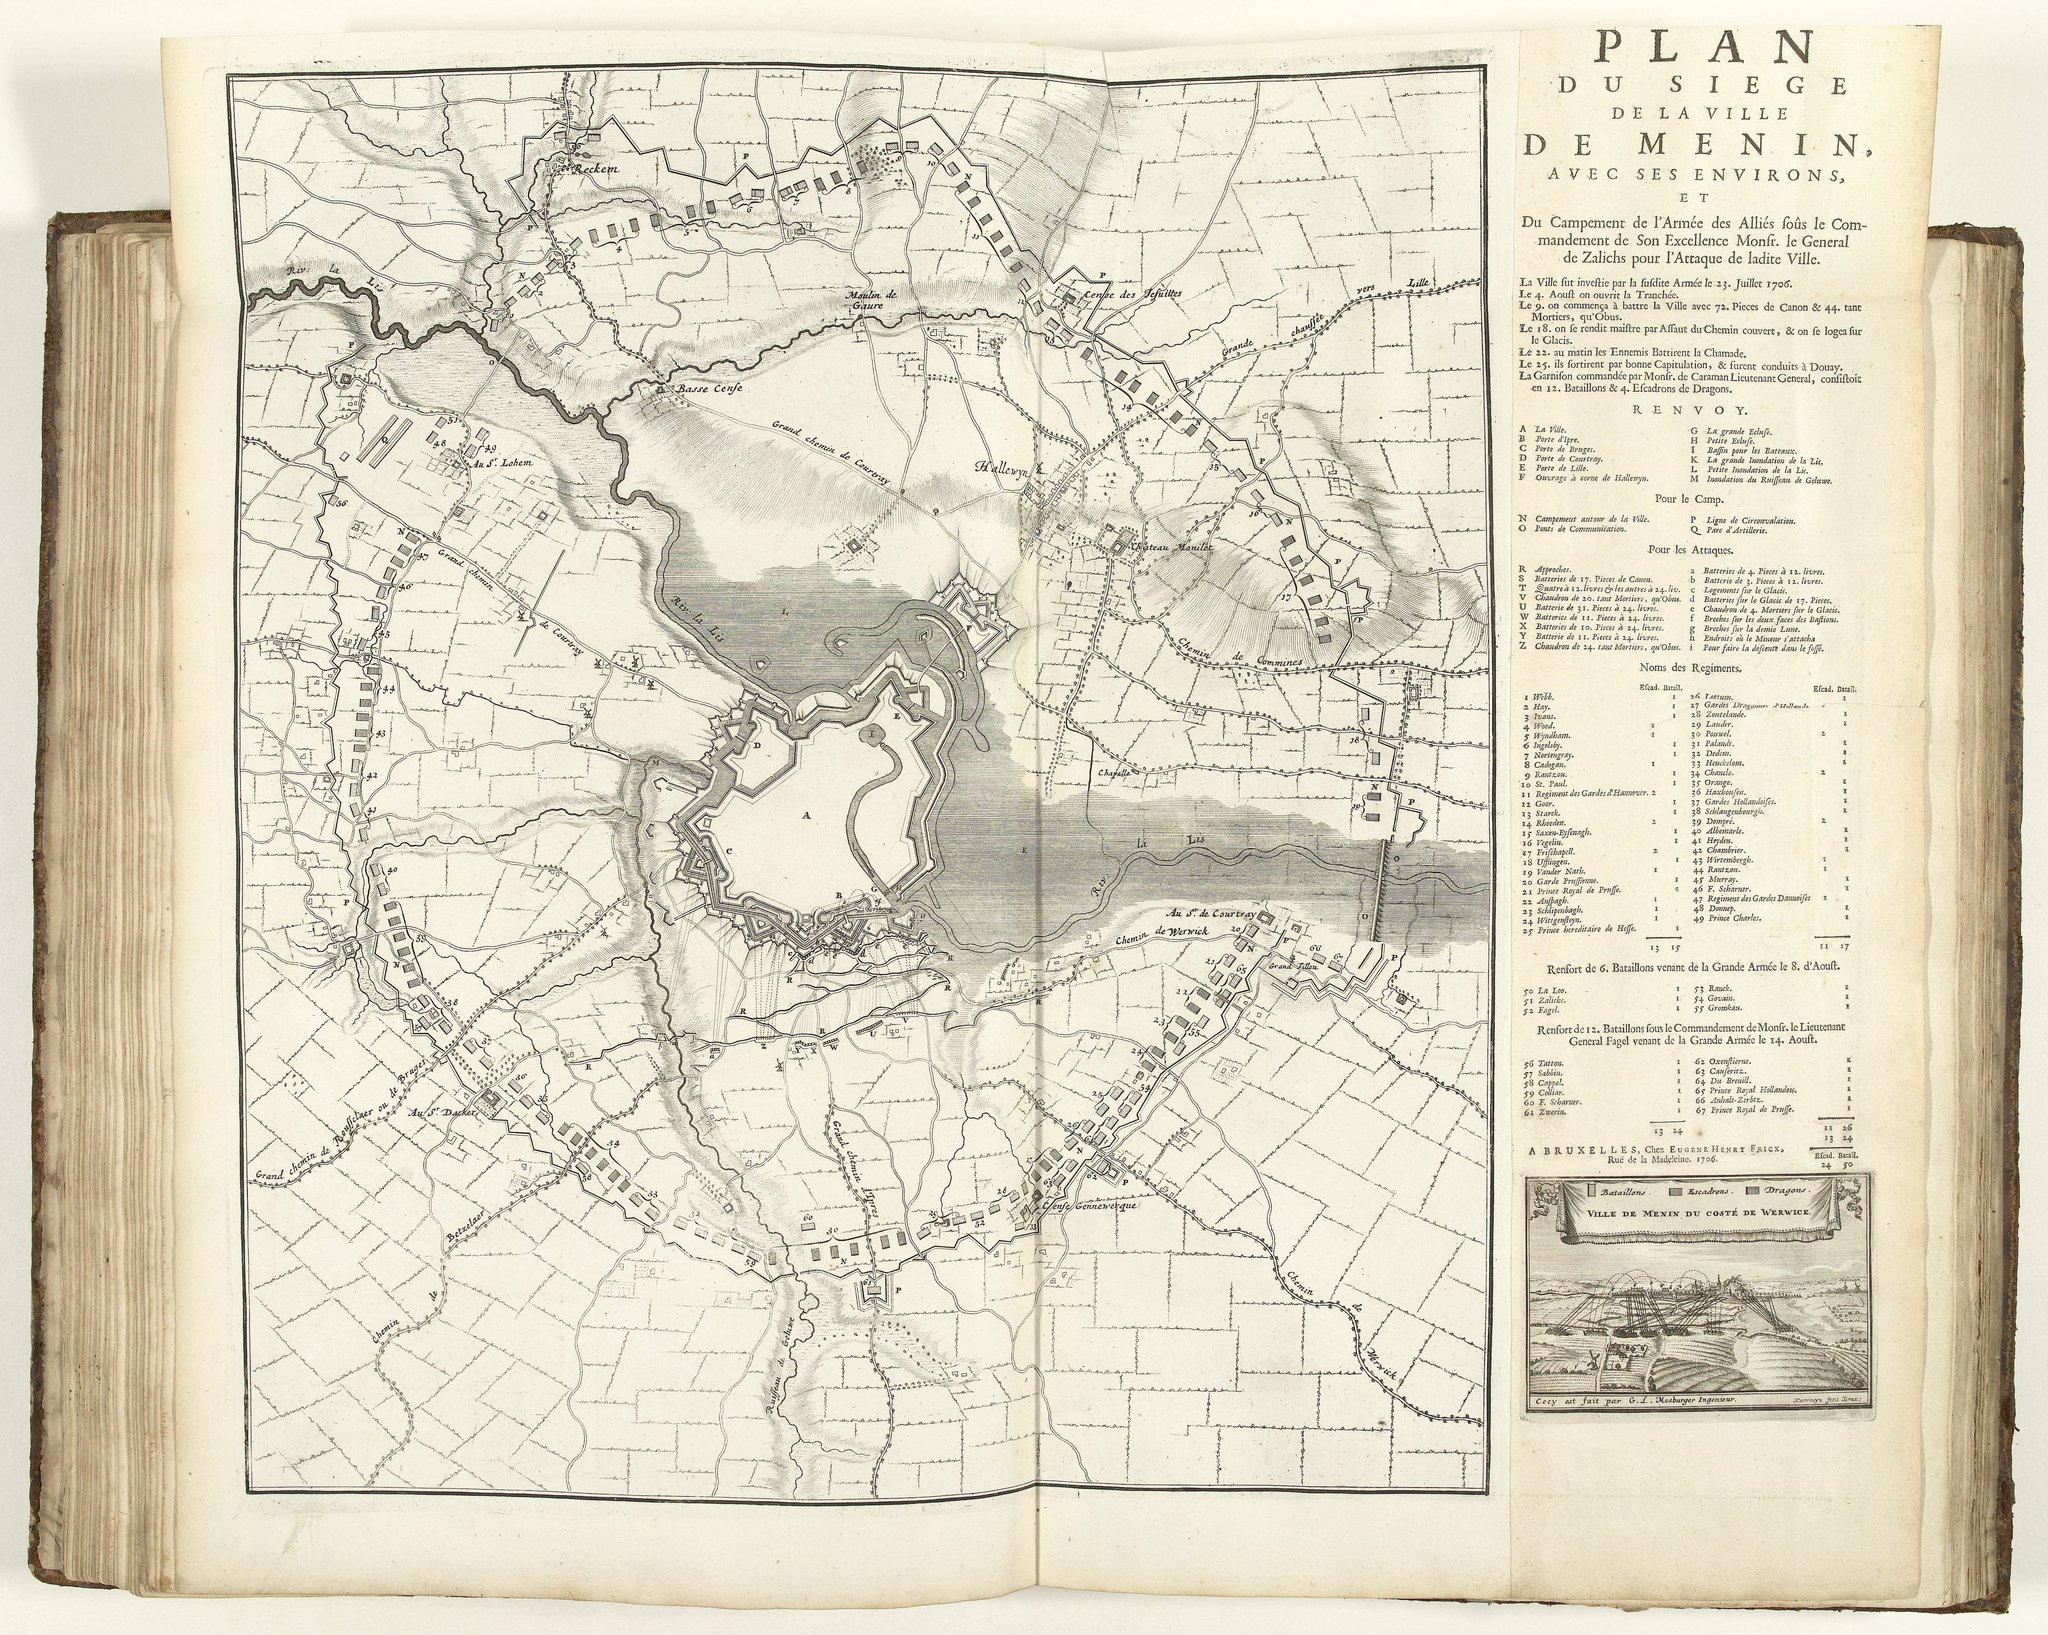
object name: print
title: Plan du Siege de la Ville de Menin avec ses Environs, et du Campement de l'Armée des Alliés soûs le Commandement de Son Excellende Monsr. le General de Zalichs pour l'Attaque de ladite Ville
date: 1706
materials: paper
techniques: etching, letterpress printing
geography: brussels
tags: maps of separate countries or regions, battle (+ land forces)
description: Kaart van het beleg van Menen door de Geallieerden onder generaal Zalichs, belegerd vanaf 23 juli, ingenomen op 22 augustus 1706. Vastgeplakt aan de rechterzijde van de prent is een tekstblad in het Frans met een lijst van de deelnemende regimenten en onderaan een gezicht op Menen, van een aparte plaat gedrukt. Onderdeel van een gebundelde verzameling van plannen van veldslagen en steden vermaard in de Spaanse Successieoorlog.